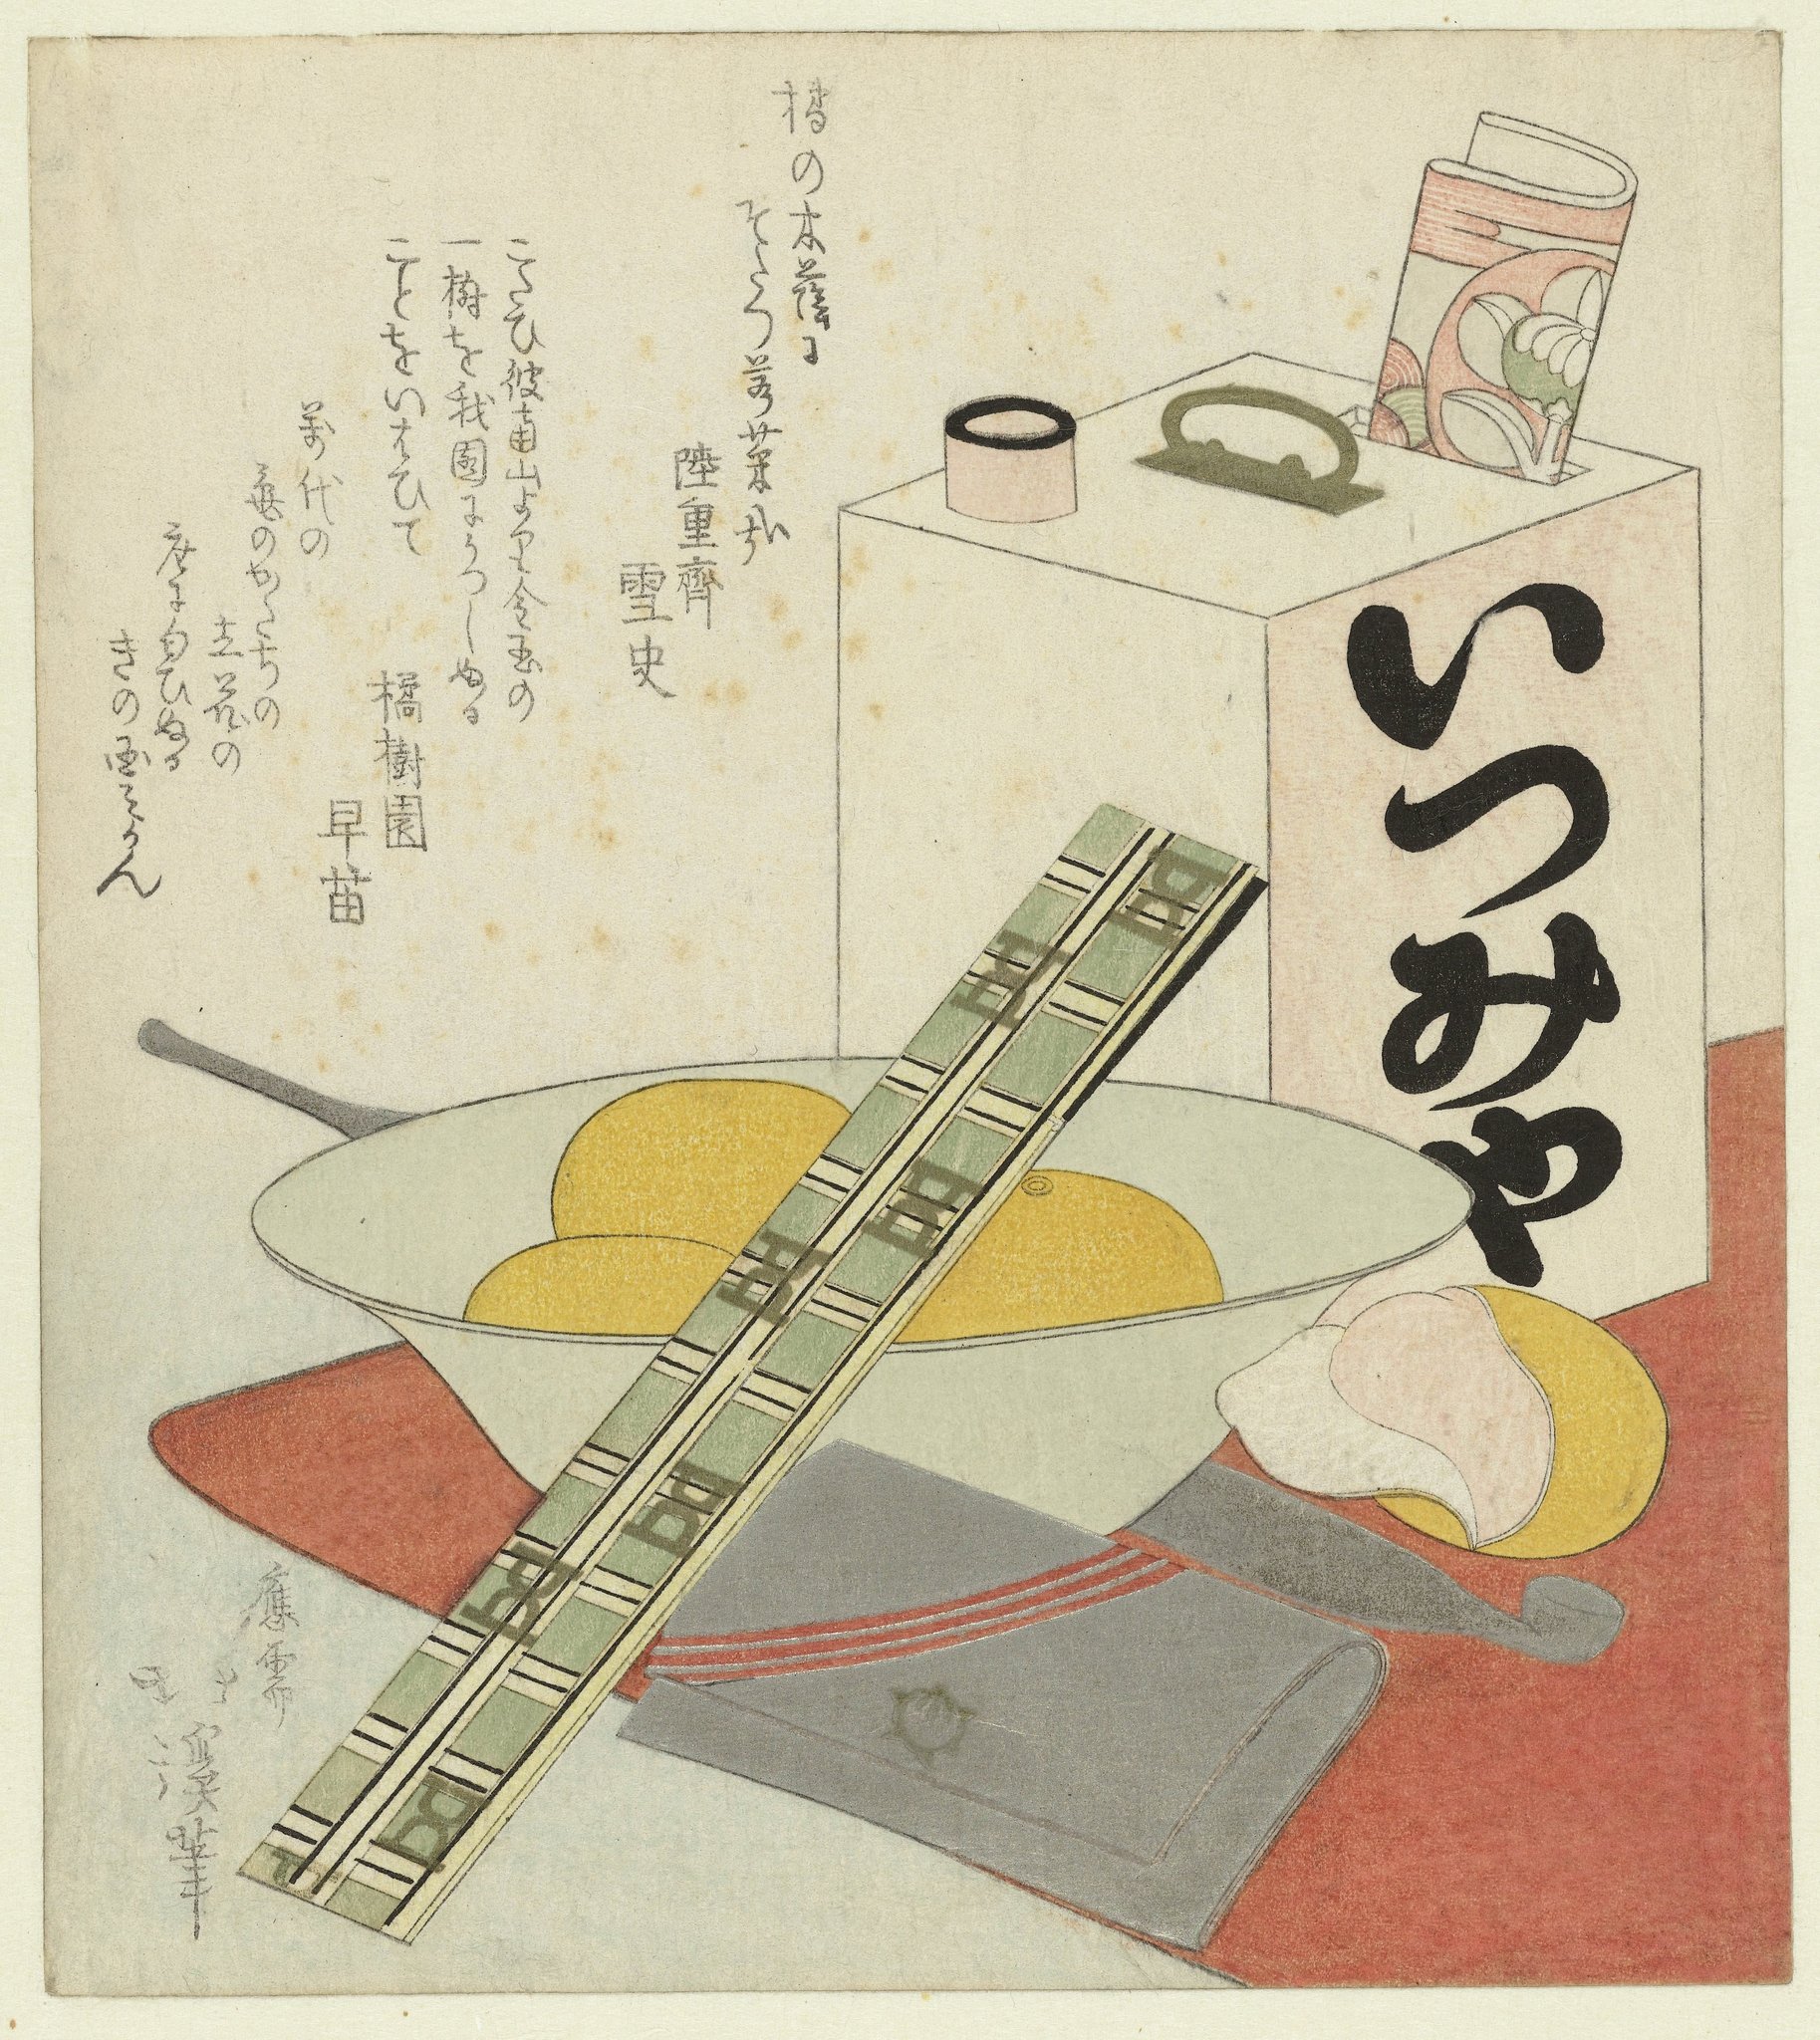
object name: surimono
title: Refreshments for a Theatre Outing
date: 1823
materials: paper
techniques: blind stamped, woodcut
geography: japan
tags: fruits: orange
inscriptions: collector's mark, passe-partout, bottom left, printed: JABdH with a rooster., collector's mark, verso, stamped: Lugt 2228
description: Een stilleven van middageten voor theater bezoekers, bestaande uit een programmaboekje, mandarijntjes in een kom met ernaast een zilveren pijp en tabakszak. Uit de doos steekt het programmaboekje waarop een mandarijnenbloesem staat afgebeeld, het familiewapen van de Ichikawa familie. Op de doos staat ´Izumiya´, waarschijnlijk de naam van een favoriet restaurant van de Ichikawa acteursfamilie. Met drie gedichten.